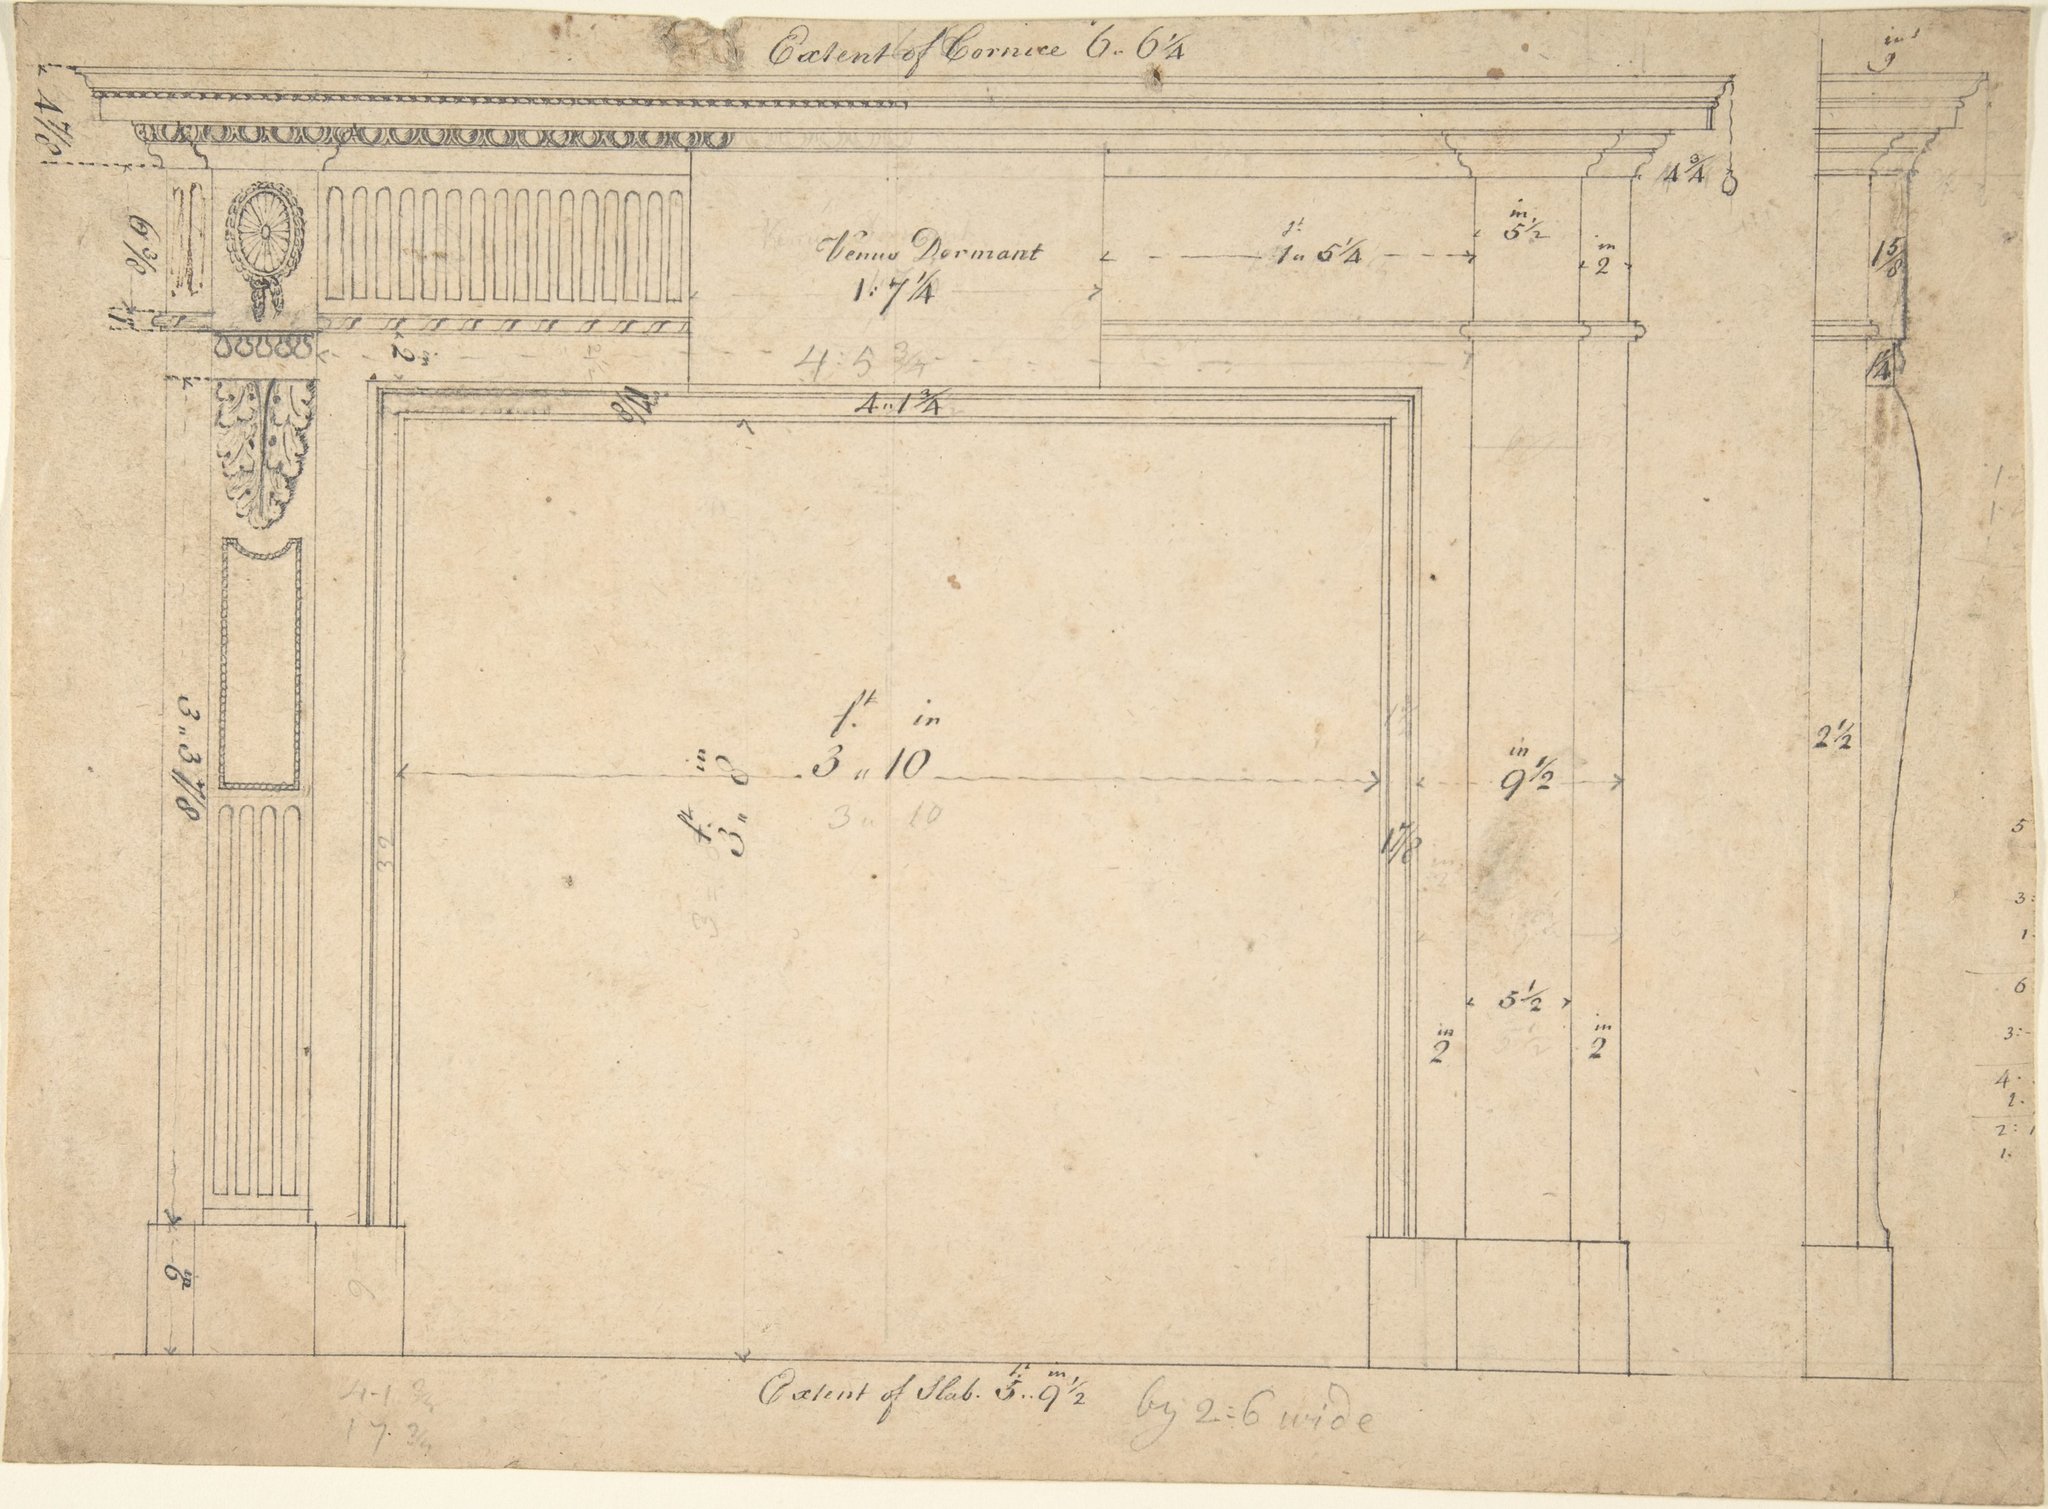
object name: drawing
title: Design for a Chimneypiece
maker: sir william chambers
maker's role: artist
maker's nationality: british, born sweden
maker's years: 1723-1796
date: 1740-1800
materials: ink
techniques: pen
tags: architecture